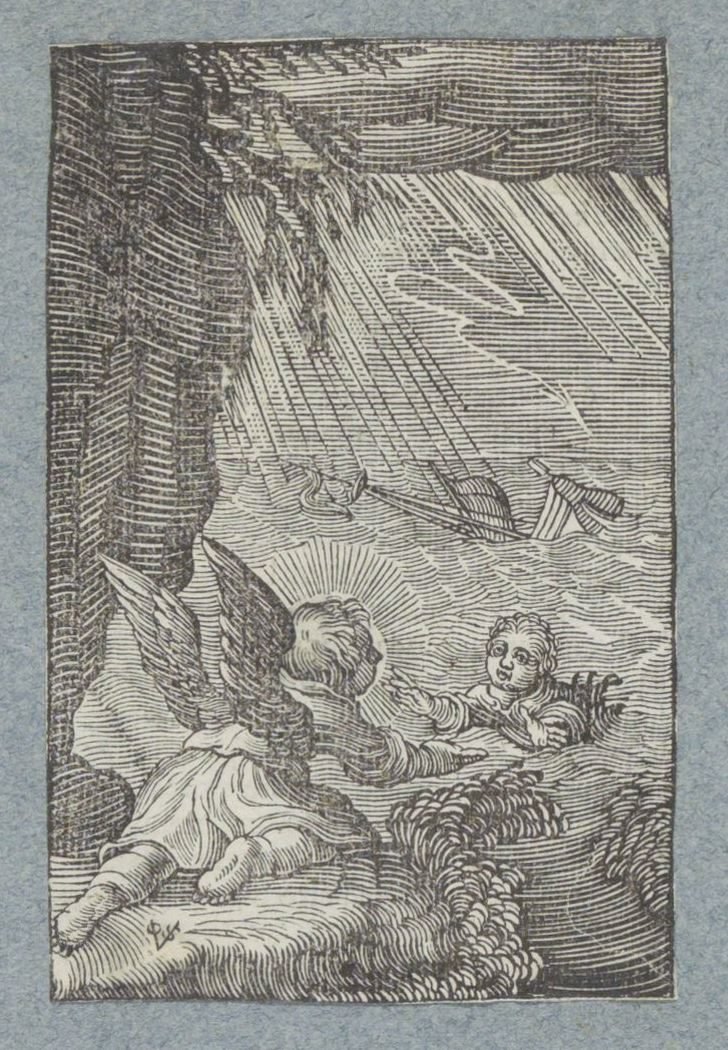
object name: book illustration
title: Engel redt kind uit zee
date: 1628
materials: paper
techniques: woodcut, pasting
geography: amsterdam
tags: drowning, shipwrecked person, saving a person from drowning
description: Prent uit: Herman Hugo, Pia desideria emblematis, elegiis & affectibus S. S. Patrum illustrata, Antwerpen 1628. Volgens de titelpagina verscheen dit werk in Antwerpen bij Hendrick Aertssens, in werkelijkheid verscheen het in Amsterdam bij Pieter Jacobsz Paets (Dietz 2012, p. 58-59).